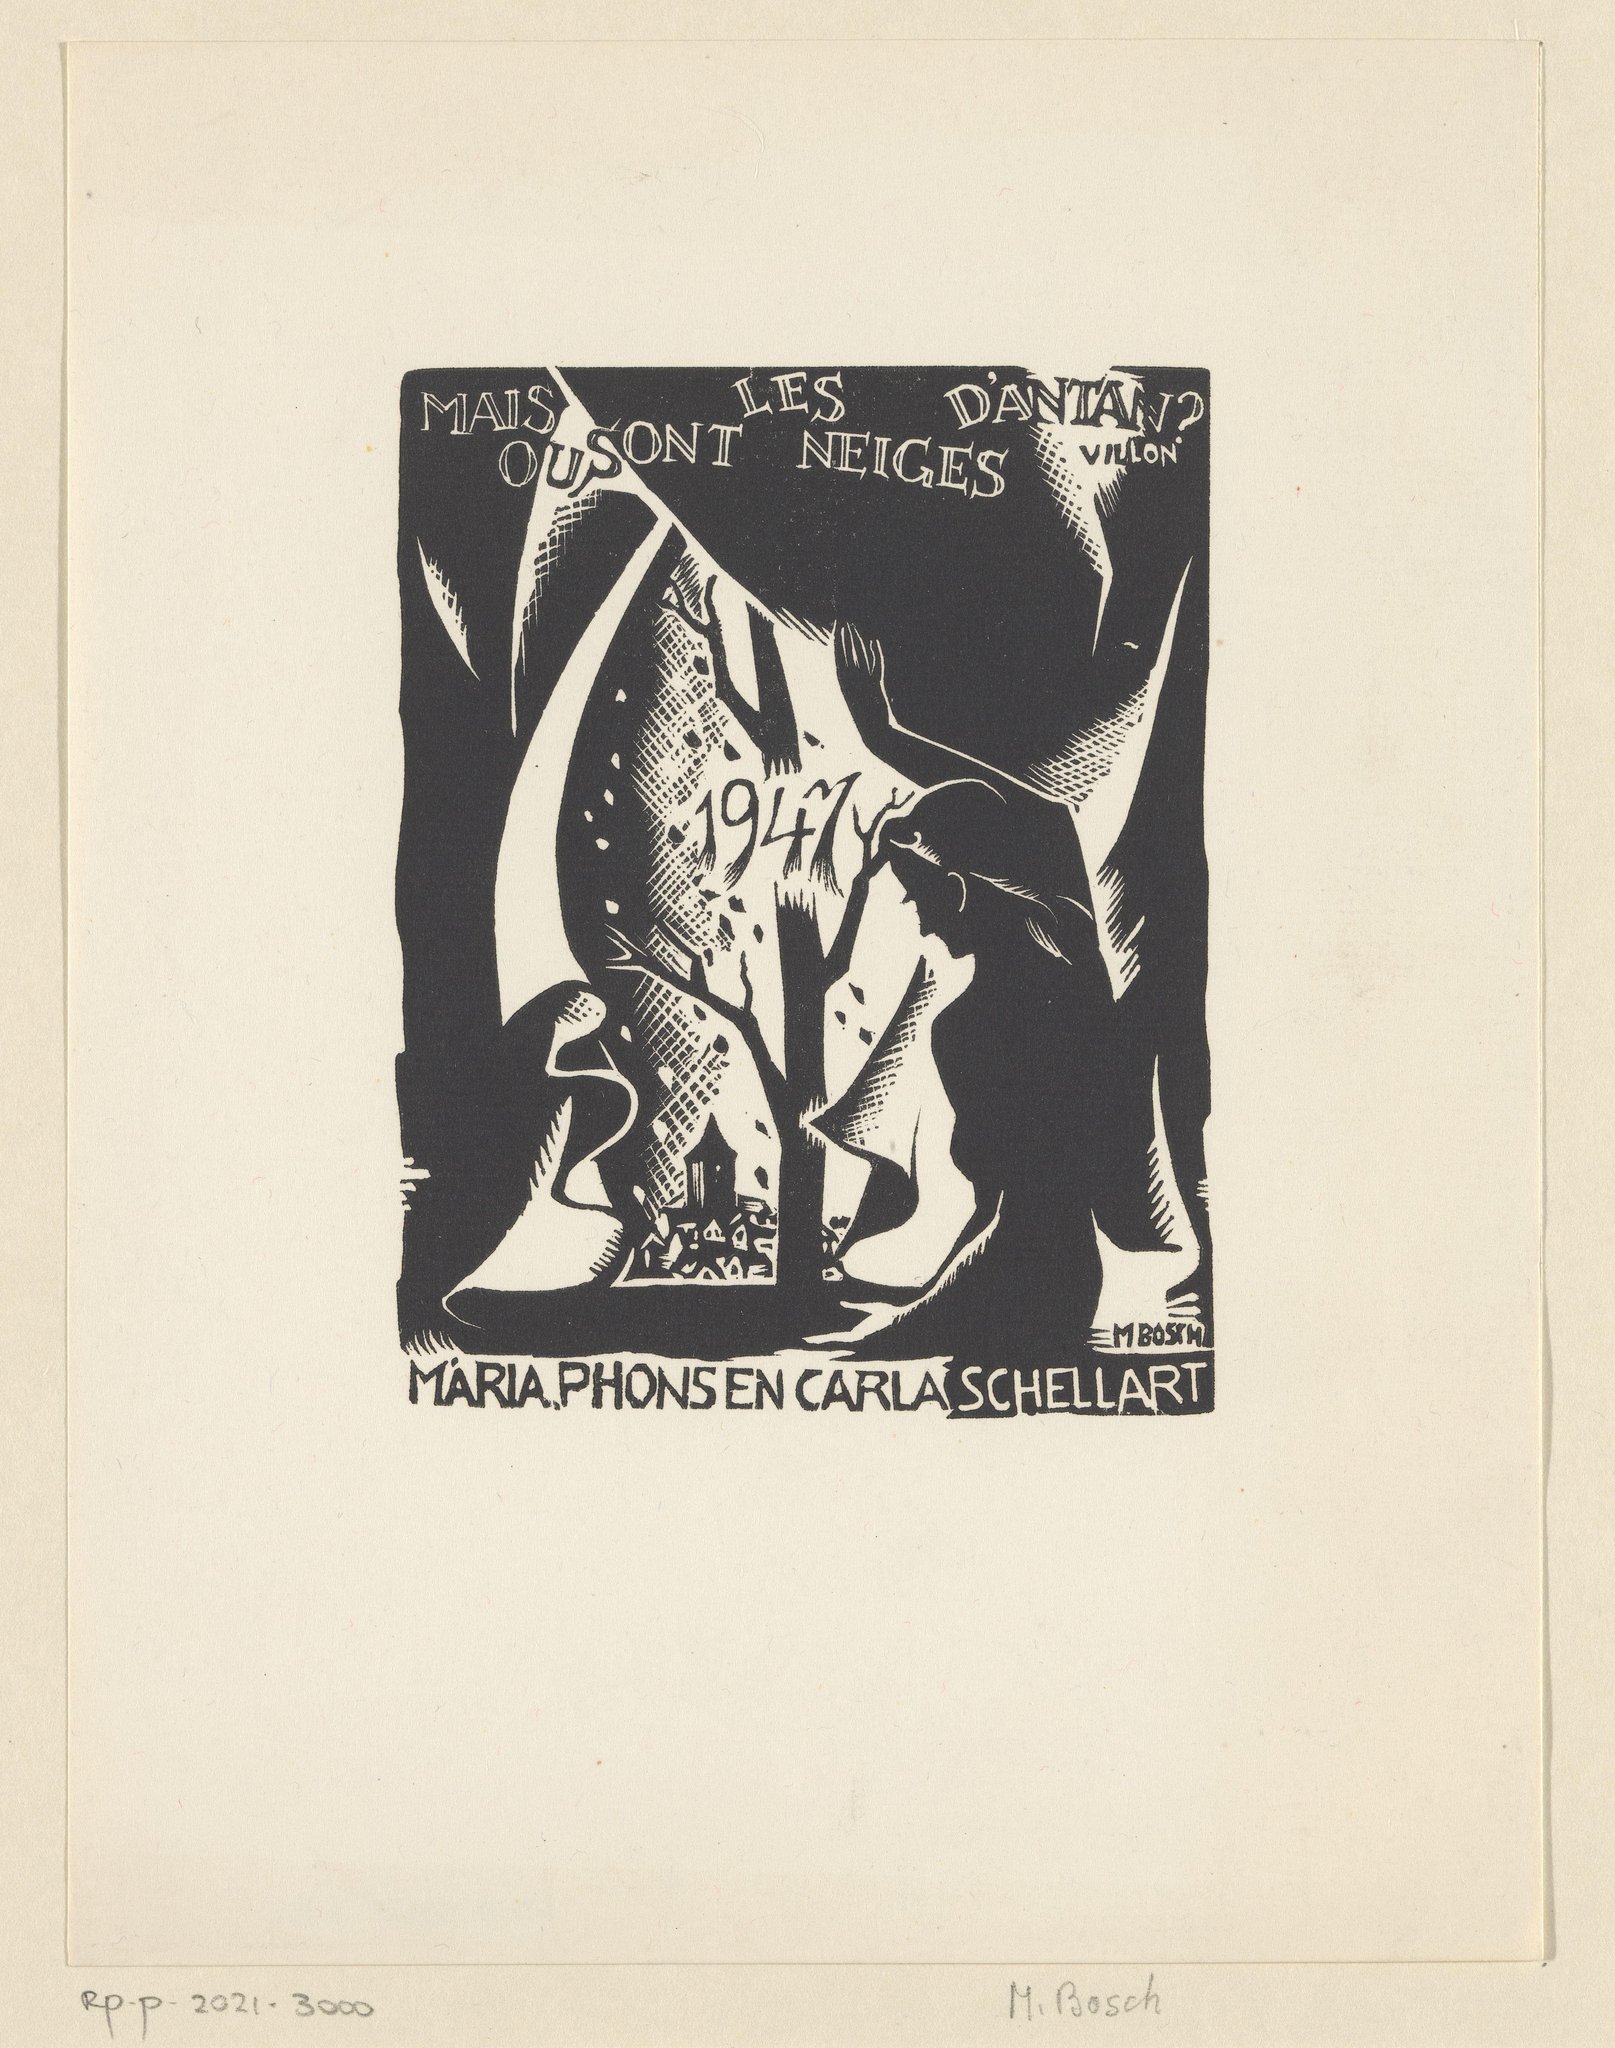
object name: print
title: Nieuwjaarswens voor 1947 van Carla, Mária en Phons Schellart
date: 1946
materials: paper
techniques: engraving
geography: france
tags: phons schellart, curtains, adolescent, young woman, maiden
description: Een vrouw houdt een gordijn opzij waarachter een boom, een stad en het jaar 1947. Daarboven de tekst: 'Mais ou sont les neiges d'antan? Villon', een zin uit het gedicht 'Ballade des dames du temps jadis' van François Villon.